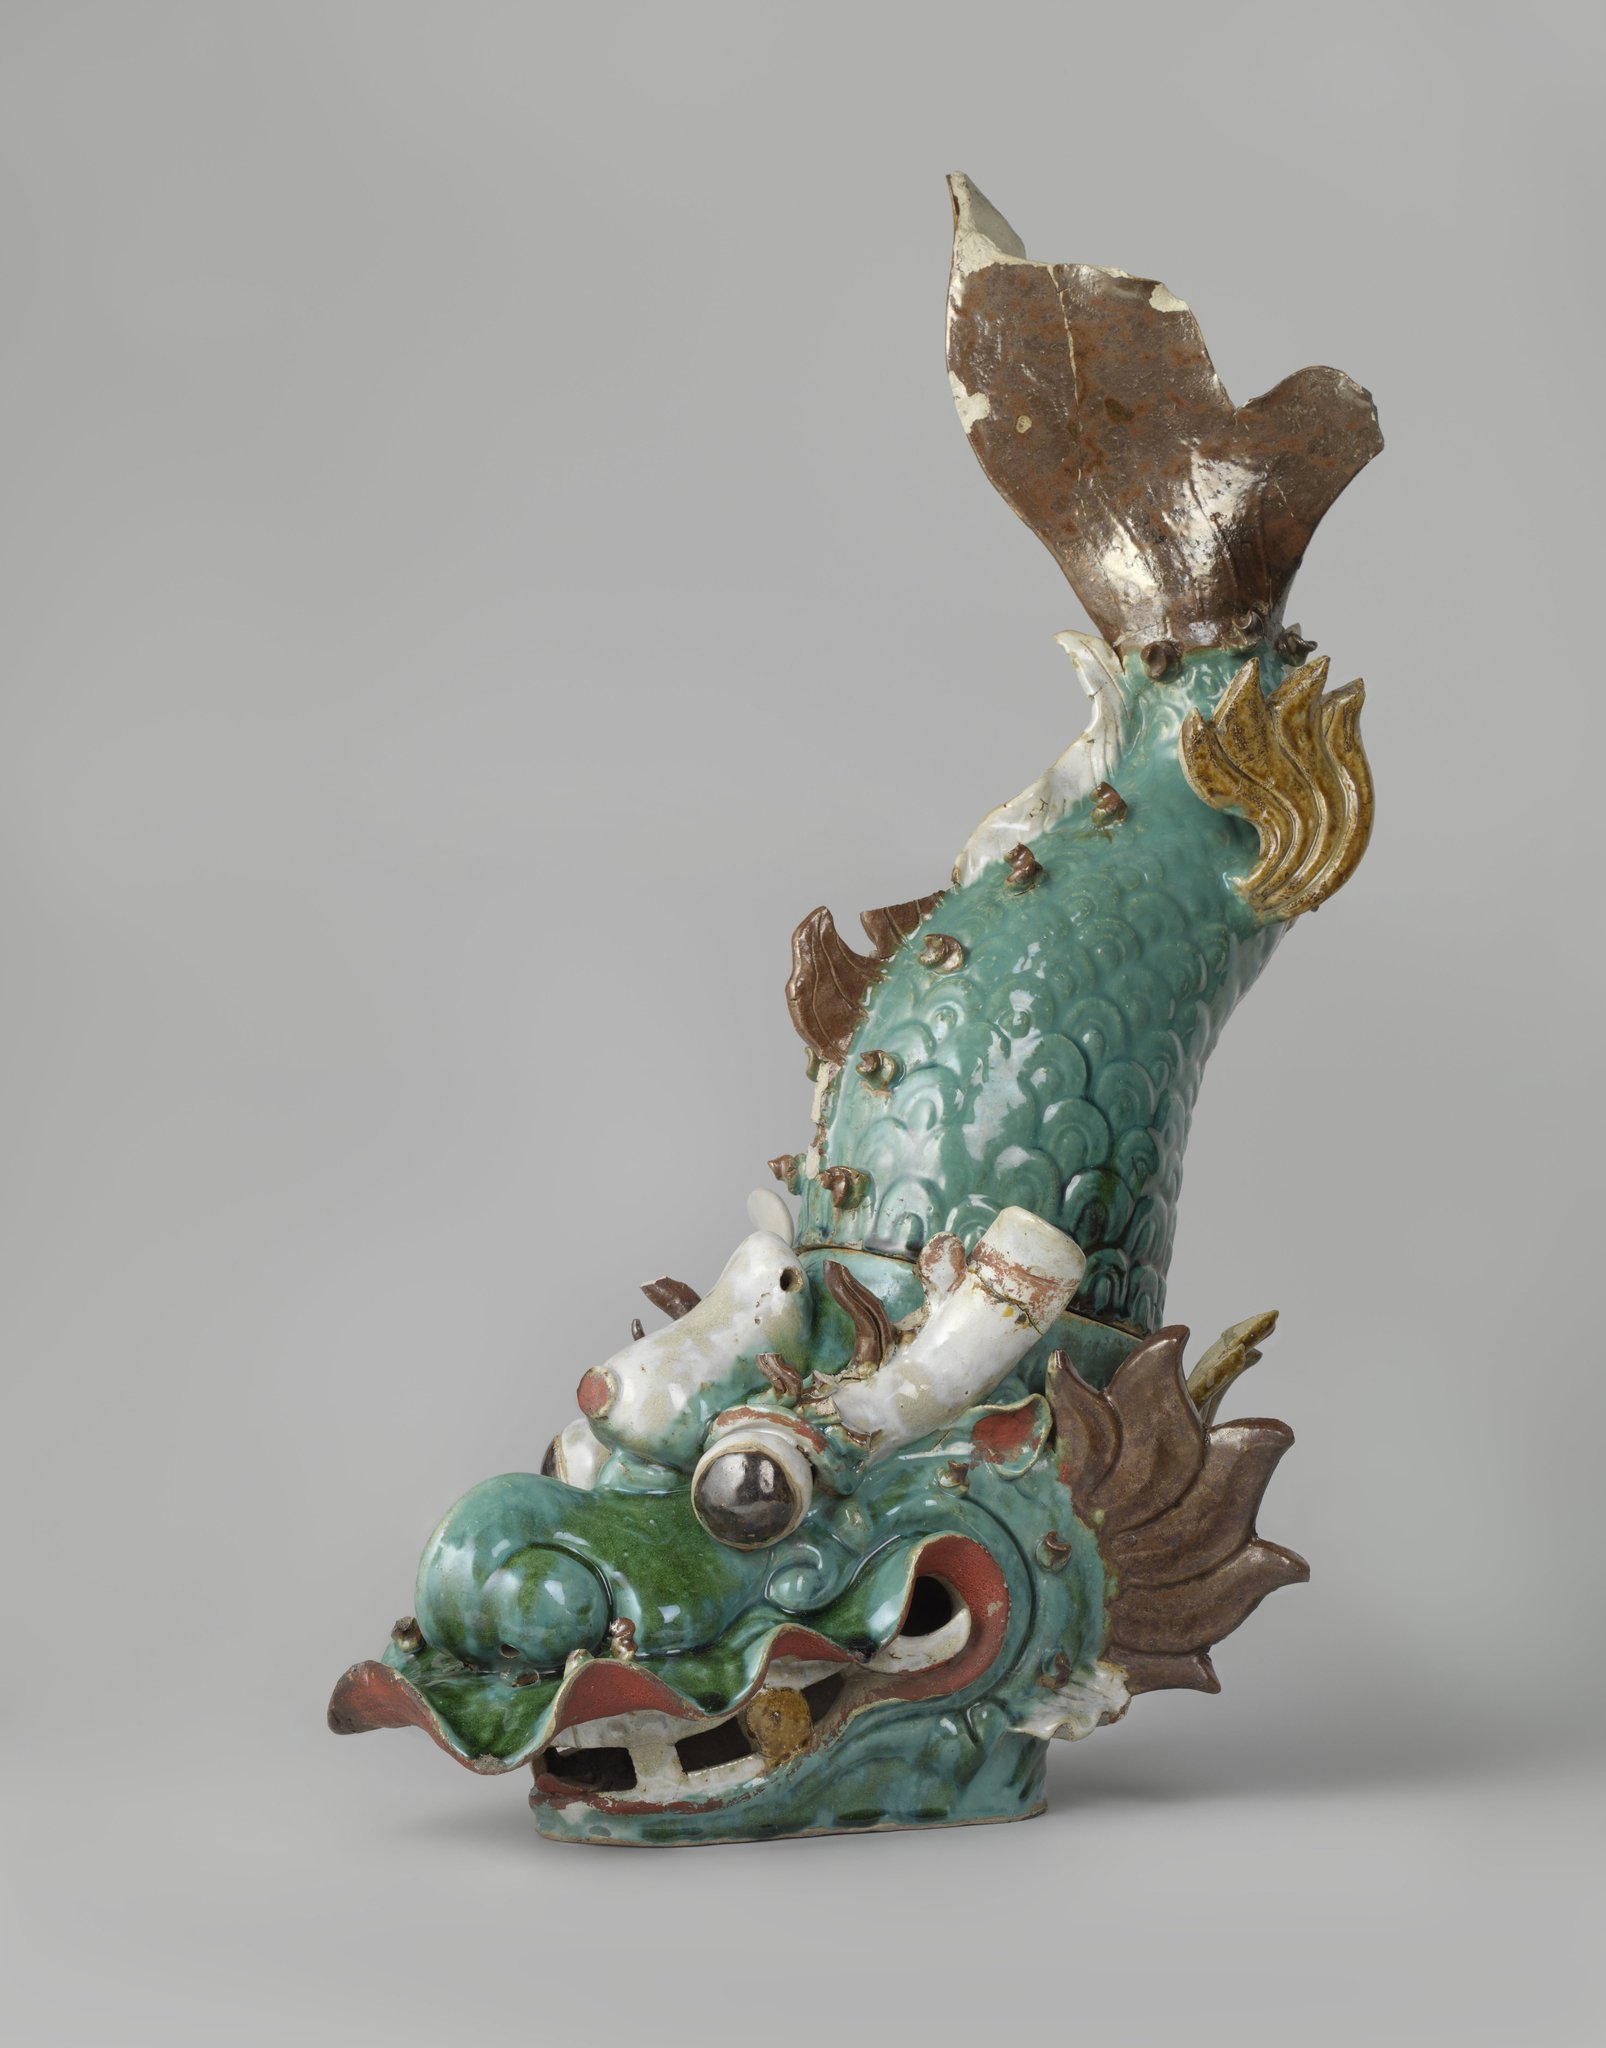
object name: sculpture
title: Draak/zeemonster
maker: Anonymous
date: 1850-1875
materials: dye, earthenware, glaze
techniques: vitrification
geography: china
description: Draak/zeemonster, bestaande uit twee delen, verbonden met een houten staaf. De draak staat op zijn onderkaak, de staart steekt omhoog. Blauw, bruin, rood en wit geglazuurd en beschilderd.